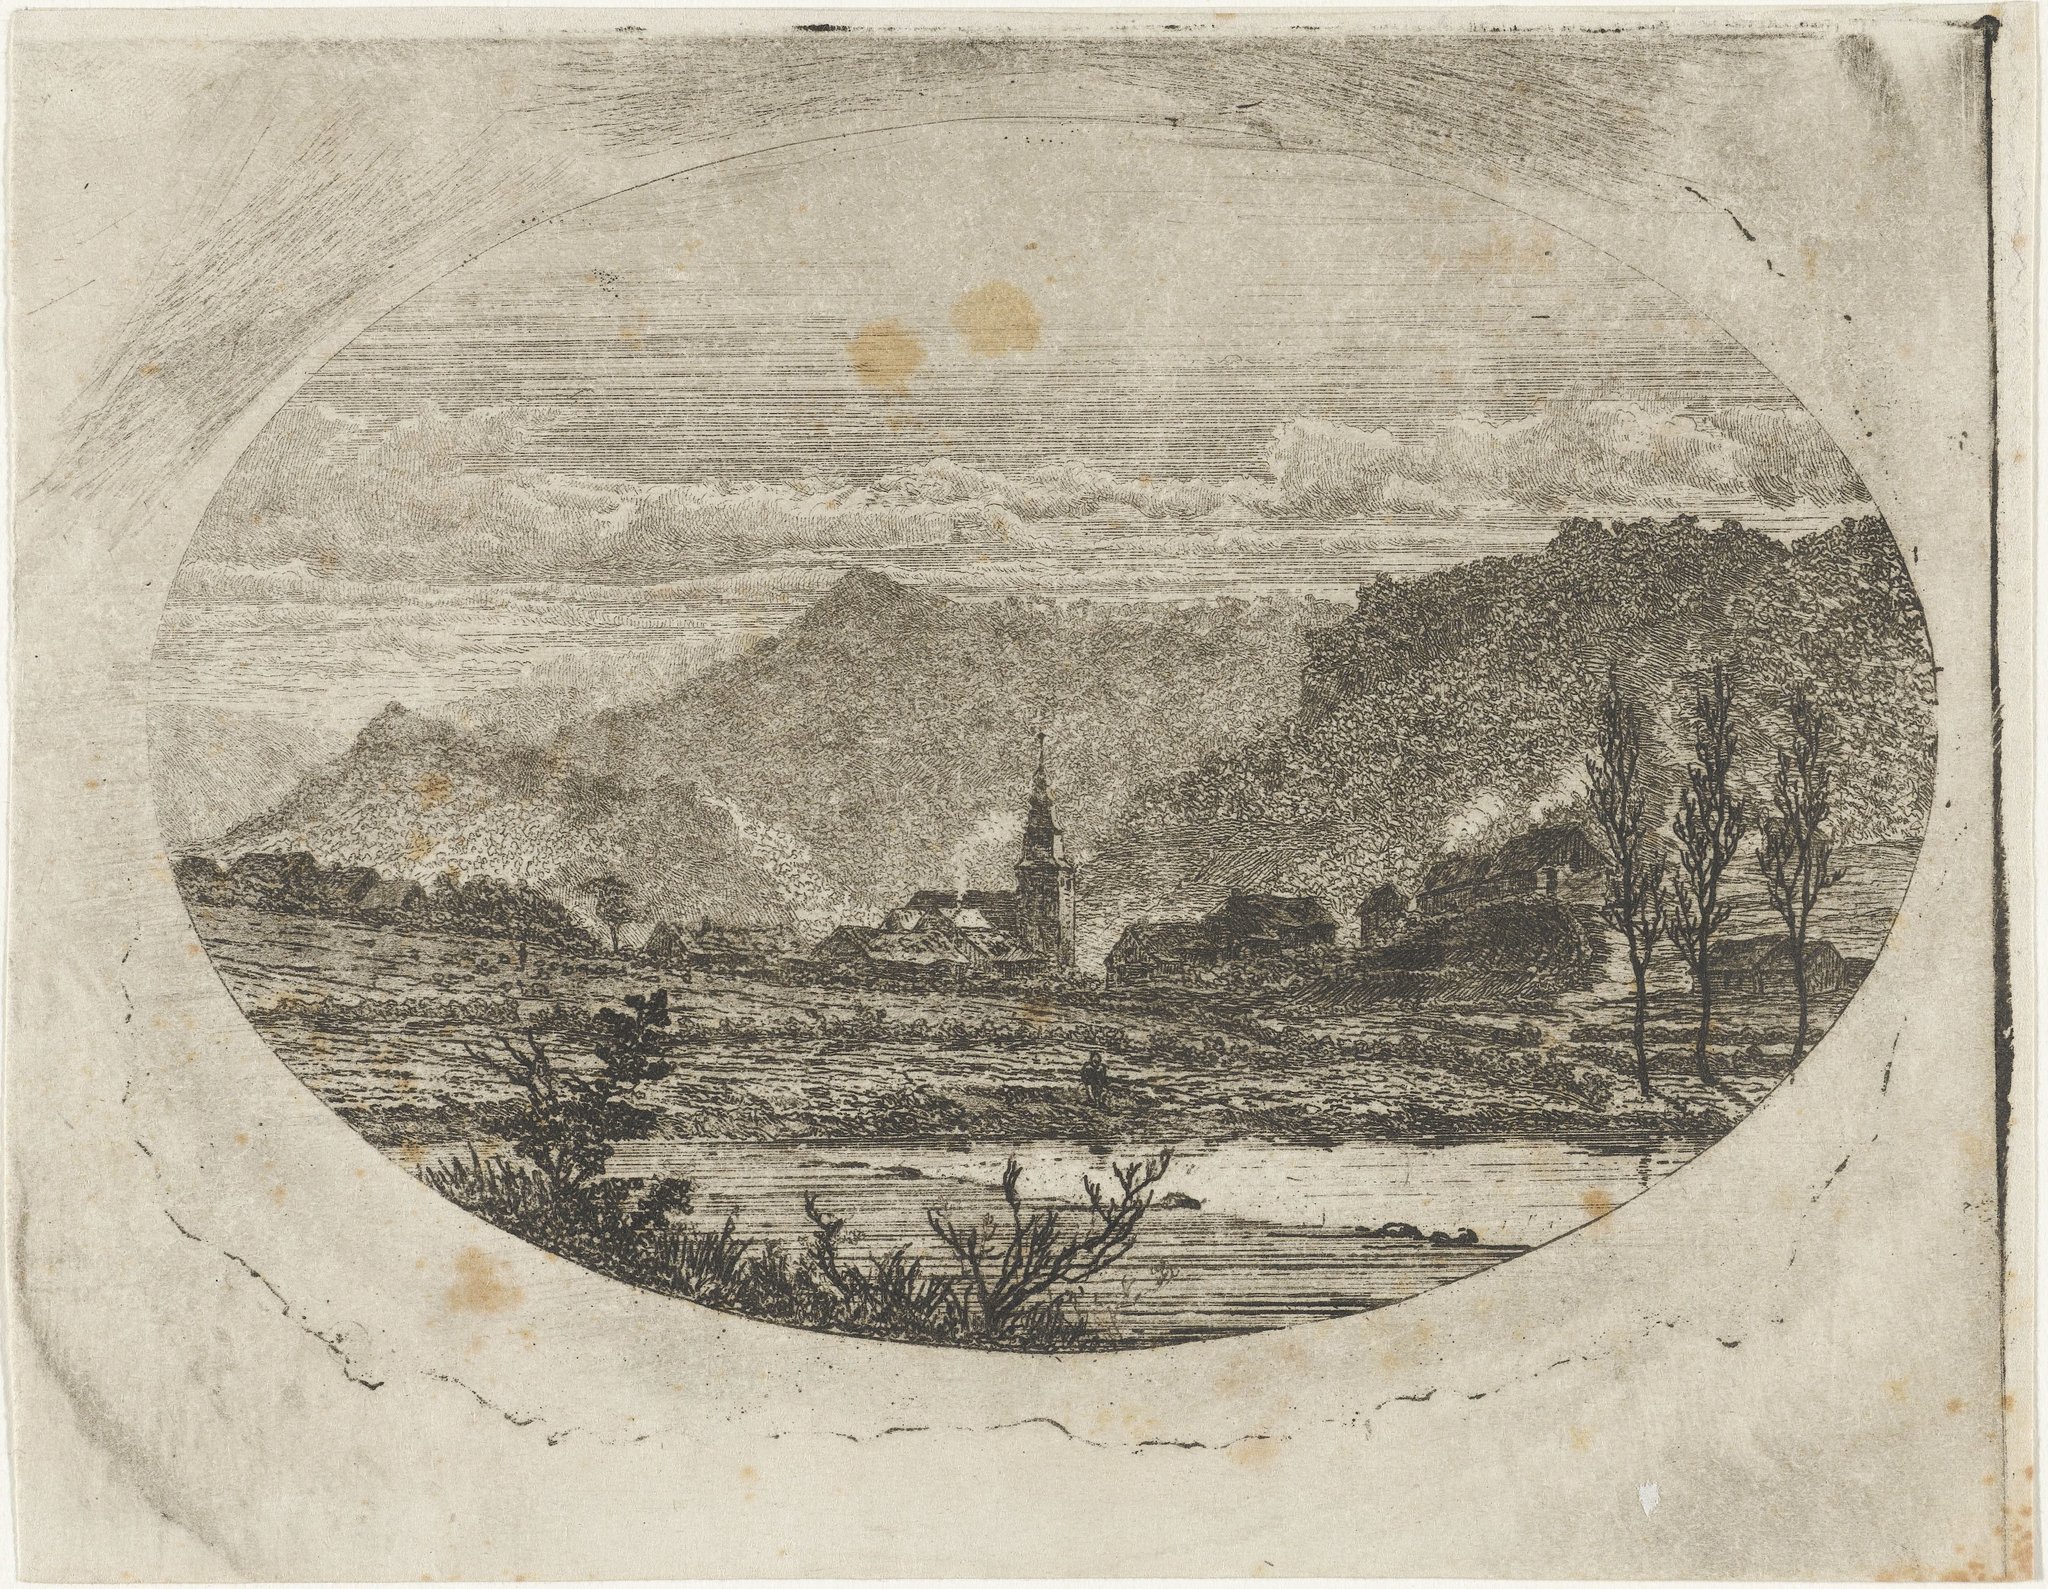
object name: print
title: Gezicht op Alle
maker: martinus antonius kuytenbrouwer jr.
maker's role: draughtsman, painter, print maker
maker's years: 1821-1897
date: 1831-1897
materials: paper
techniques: drypoint, etching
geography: netherlands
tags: river, village, church (exterior), mountains, belgium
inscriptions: collector's mark: Lugt 2228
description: proefdruk van een illustratie voor: Alexis Victor Joly, Les Ardennes, Brussel: J. van Bruggenhoudt, 1854-1857.